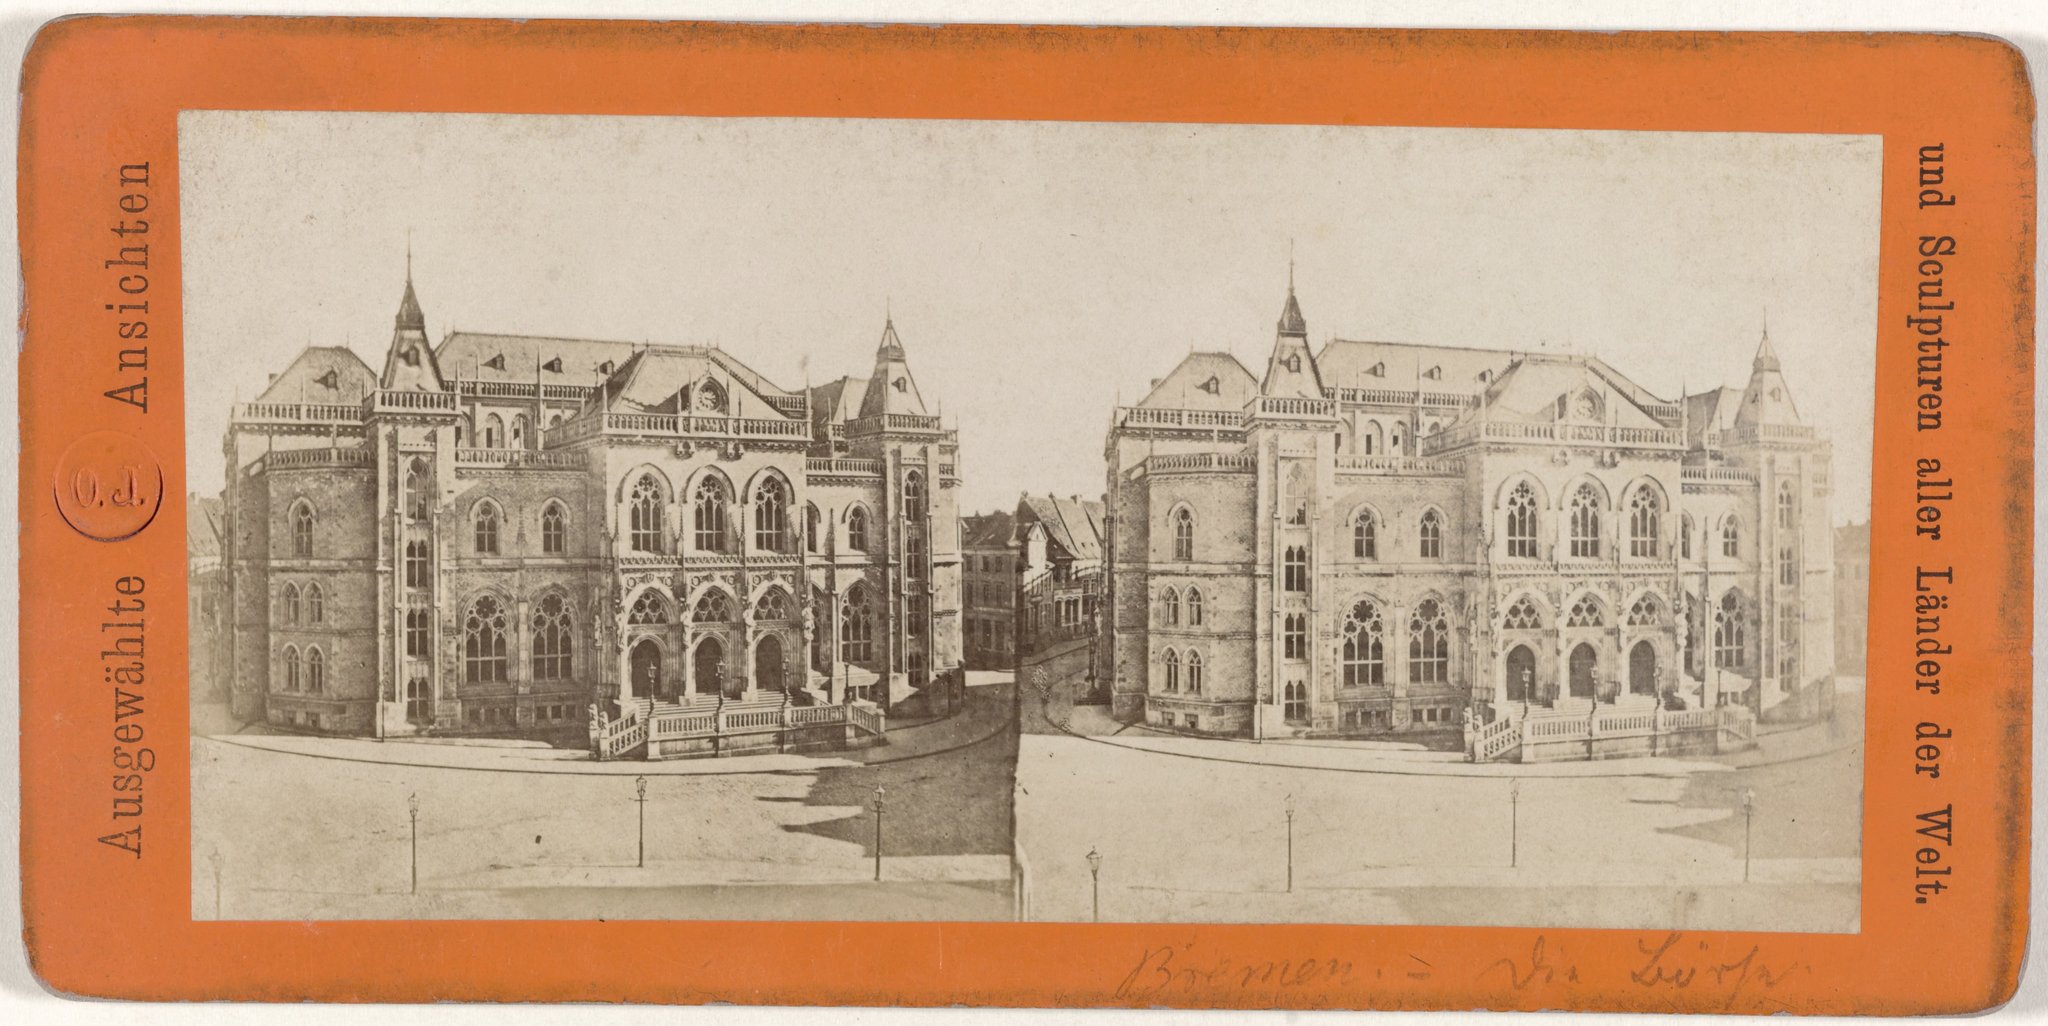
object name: stereograph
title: Exterieur van de beurs van Bremen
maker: o.j.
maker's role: fotograaf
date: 1873-1890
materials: cardboard, paper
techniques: albumen print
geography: bremen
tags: exterior ~ representation of a building, exchange, bourse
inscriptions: number: ‘591’, number: ‘801’